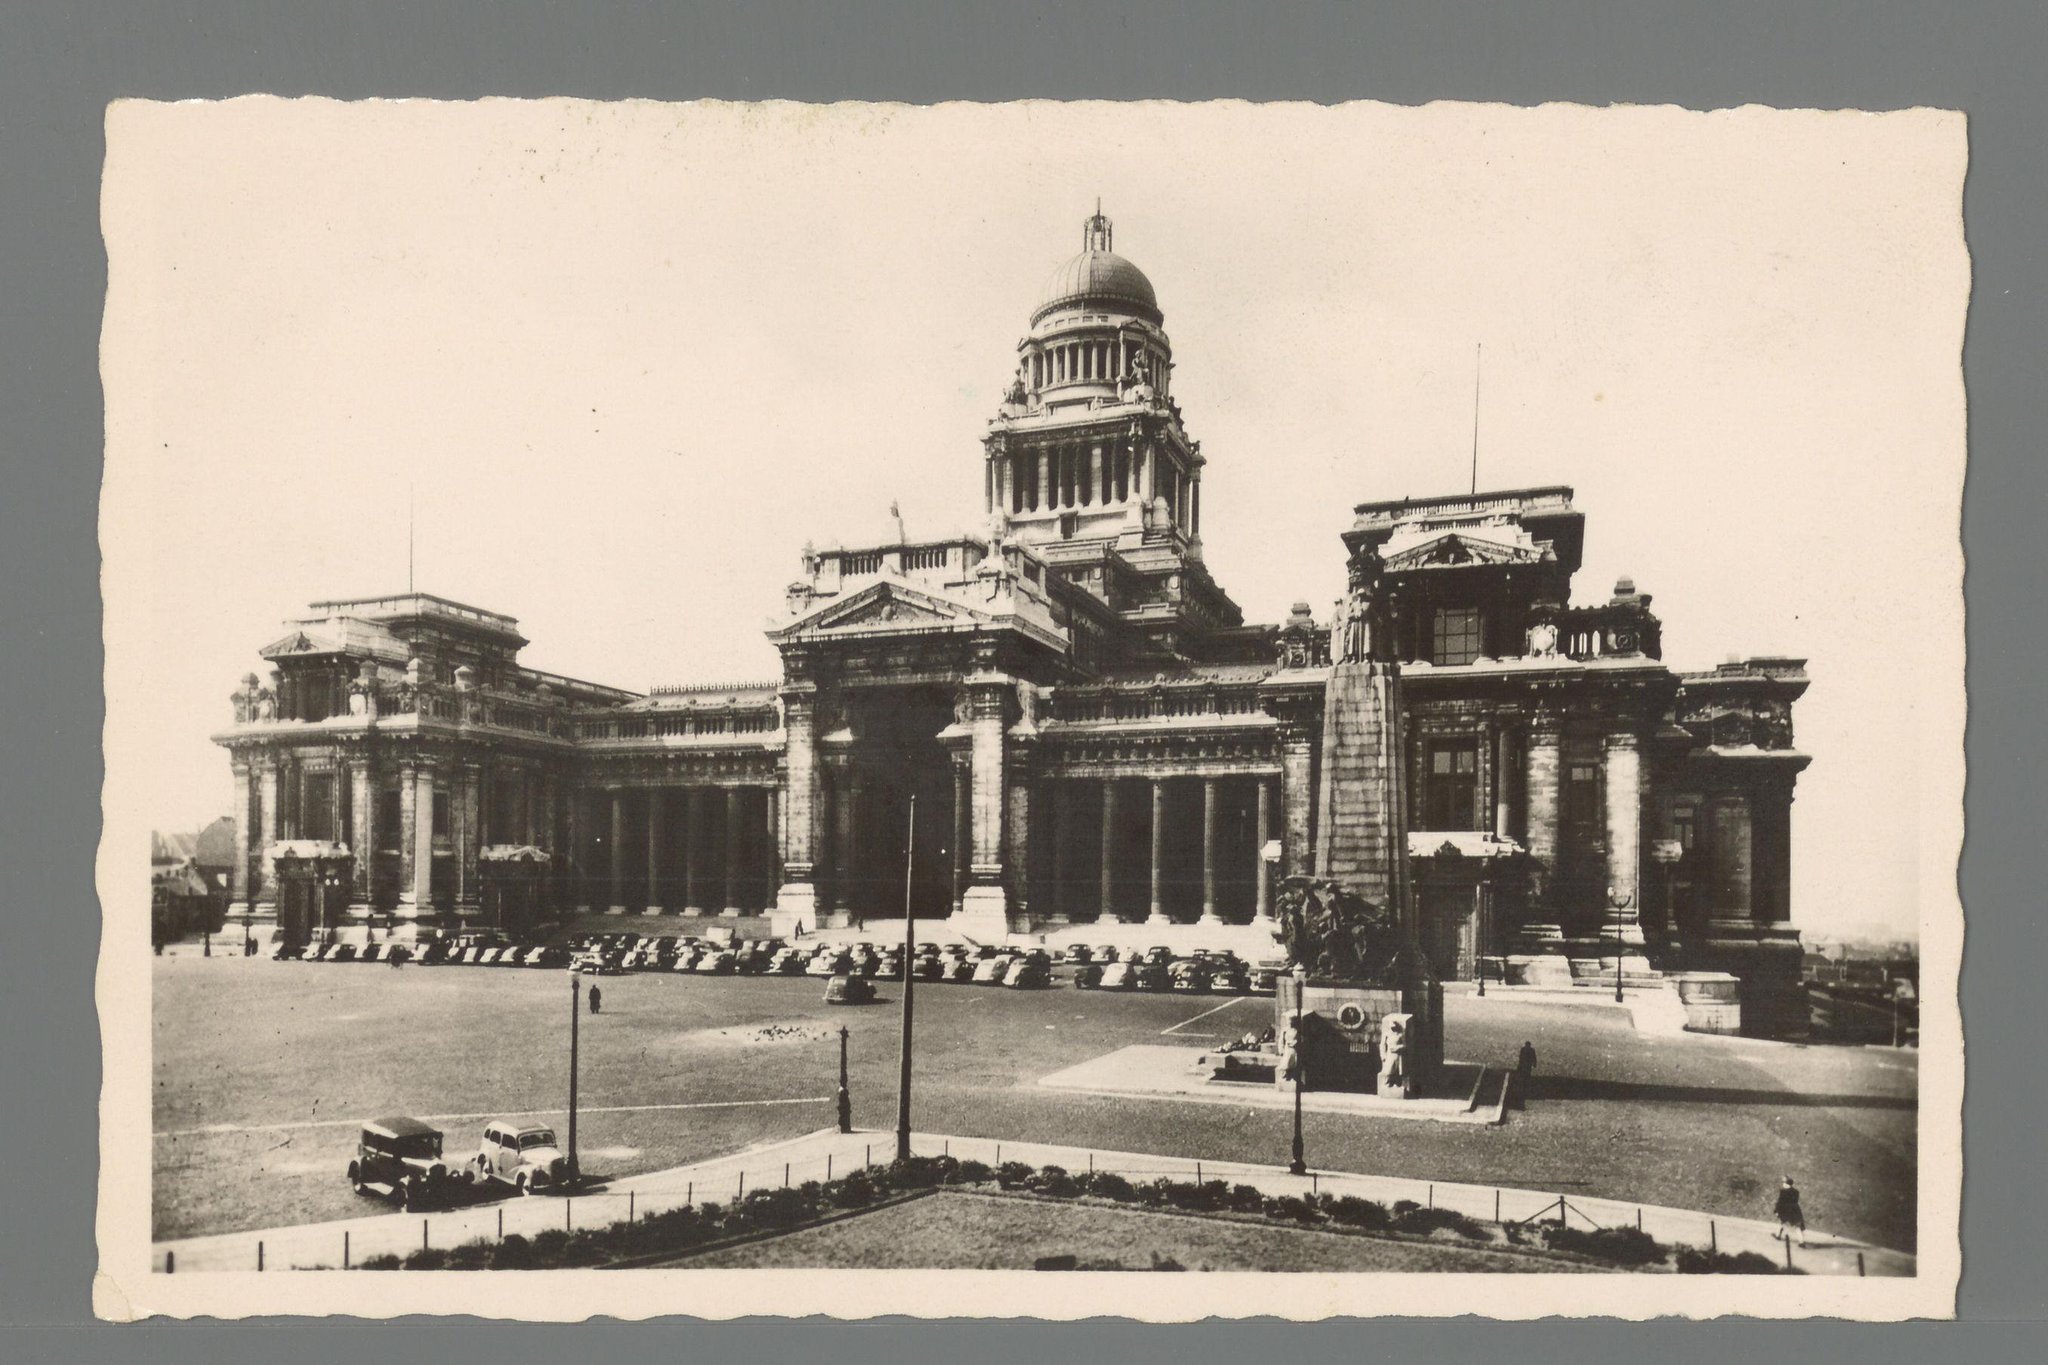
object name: ansichtkaart, prentbriefkaart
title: Bruxelles. Palais de Justice / Brussel. Justitie Paleis / Brussels Courts of Justice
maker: Anonymous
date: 1906-1950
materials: photographic support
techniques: photography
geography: brussels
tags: square, place, circus, etc., court building